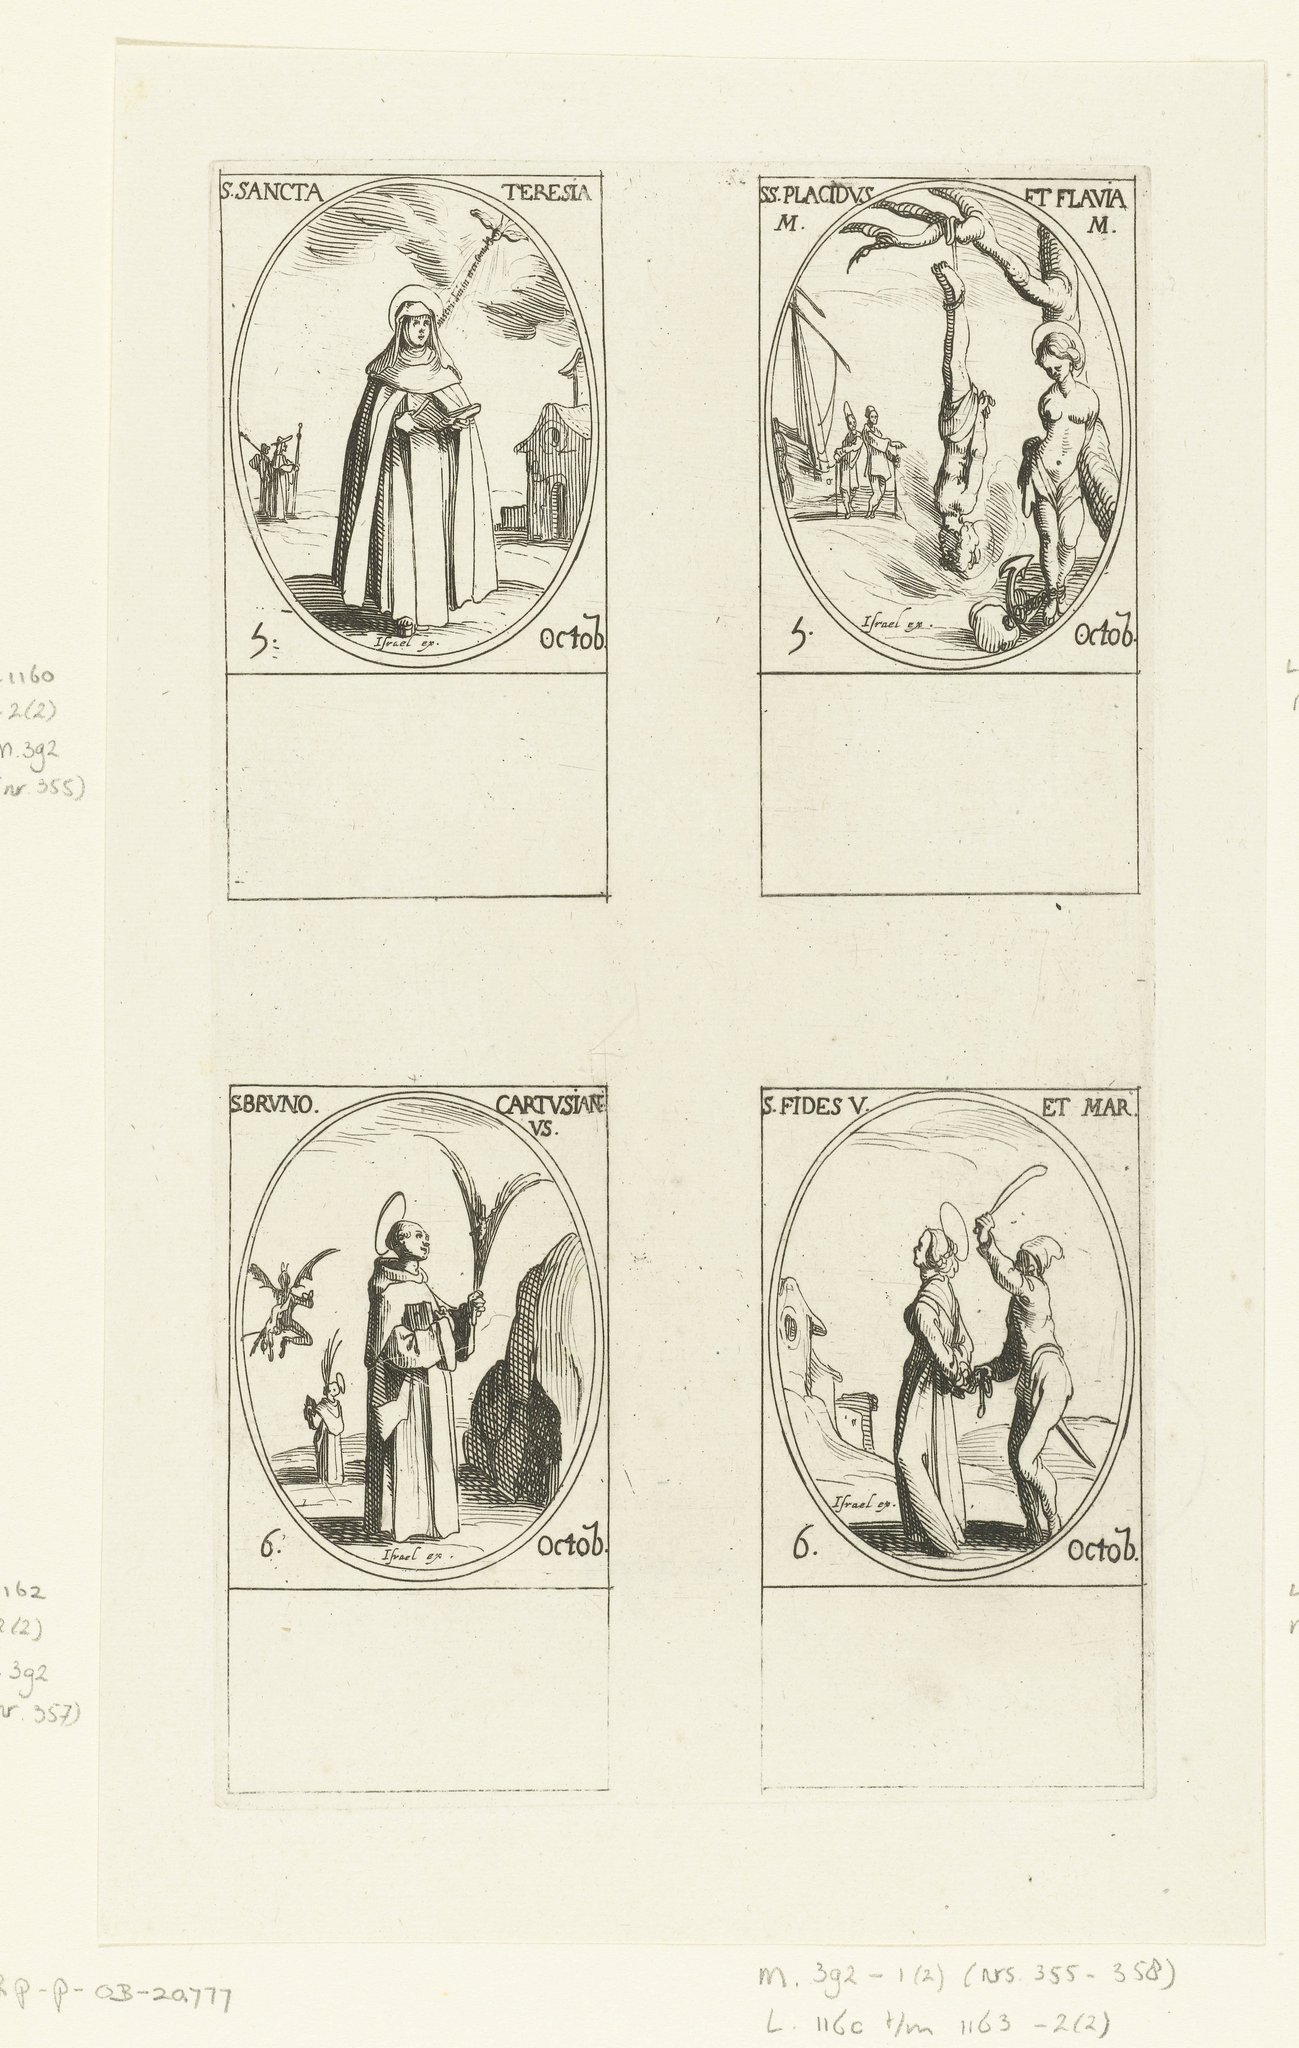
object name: print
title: Heilige Theresia van Avila, Heilige Placidus en Heilige Flavia van Subiaco, Heilige Bruno de Kartuizer, Heilige Fides van Agen (5-6 oktober)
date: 1632-1636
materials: paper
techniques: etching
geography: paris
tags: the founder of the order of the carthusians, bruno; possible attributes: cross, finger at lips, lily, mitre at his feet, olive-branch, ray of light, skull, (seven) star(s), martyrdom, suffering, misfortune, death of st. faith, female saints (with name), male saints (with name), st. theresa sees a dove, that perches on her head or shoulder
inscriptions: collector's mark: Lugt 240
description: Blad met vier ovale voorstellingen, elk met opschrift en datum in het Latijn: linksboven de Heilige Theresia van Avila die door een duif wordt toegesproken, rechtsboven de Heilige Placidus en de Heilige Flavia die door piraten gemarteld worden, linksonder de Heilige Bruno de Kartuizer met een crucifix waaraan palmbladeren groeien, rechtsonder de Heilige Fides van Agen die geslagen wordt met een knuppel. Deze prent is onderdeel van een serie prenten met voorstellingen van de heiligen en de christelijke feestdagen van het jaar. Er zijn steeds vier scènes van één plaat op één blad gedrukt. Inclusief bijbehorend titelblad en frontispice gaat het in totaal om 124 platen (490 voorstellingen). De drie platen met de laatste 12 scènes (de veranderlijke christelijke feestdagen) zijn in de derde staat versneden tot 12 kleine plaatjes, en met een apart titelblad uitgegeven.